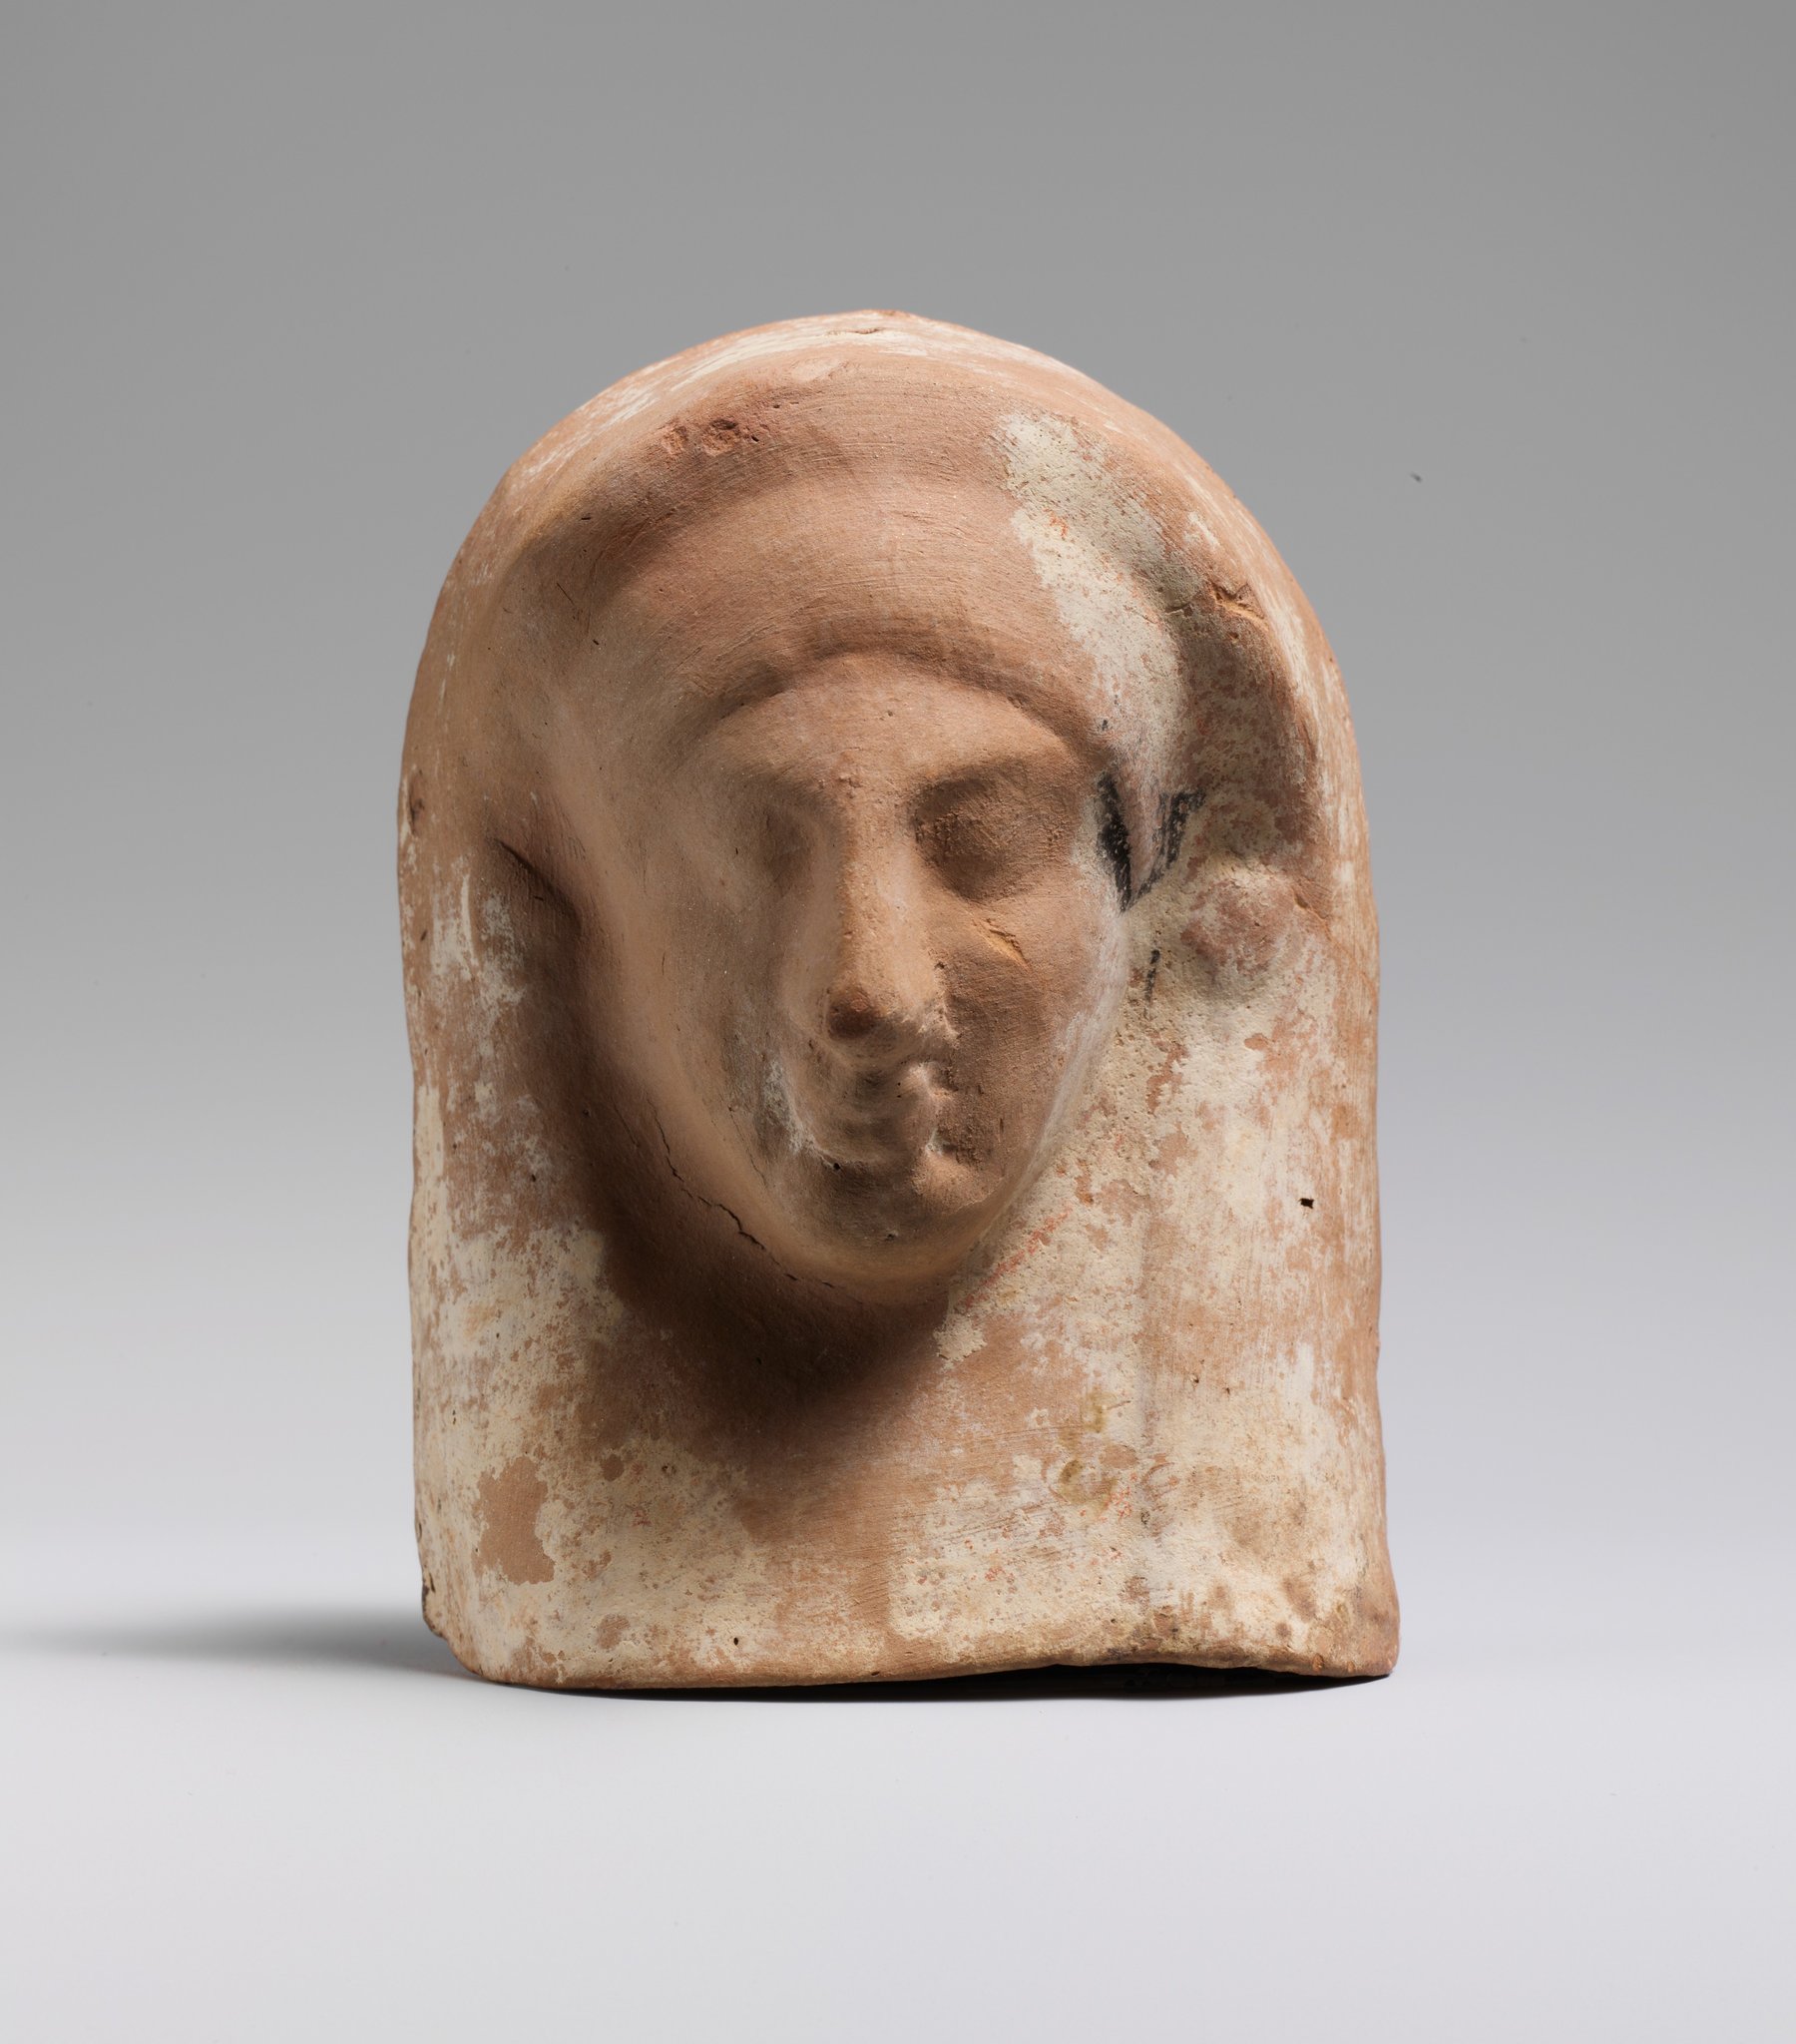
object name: mask of a woman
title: Terracotta relief with head of a woman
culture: east greek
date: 500-450 BCE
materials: terracotta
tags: heads,women